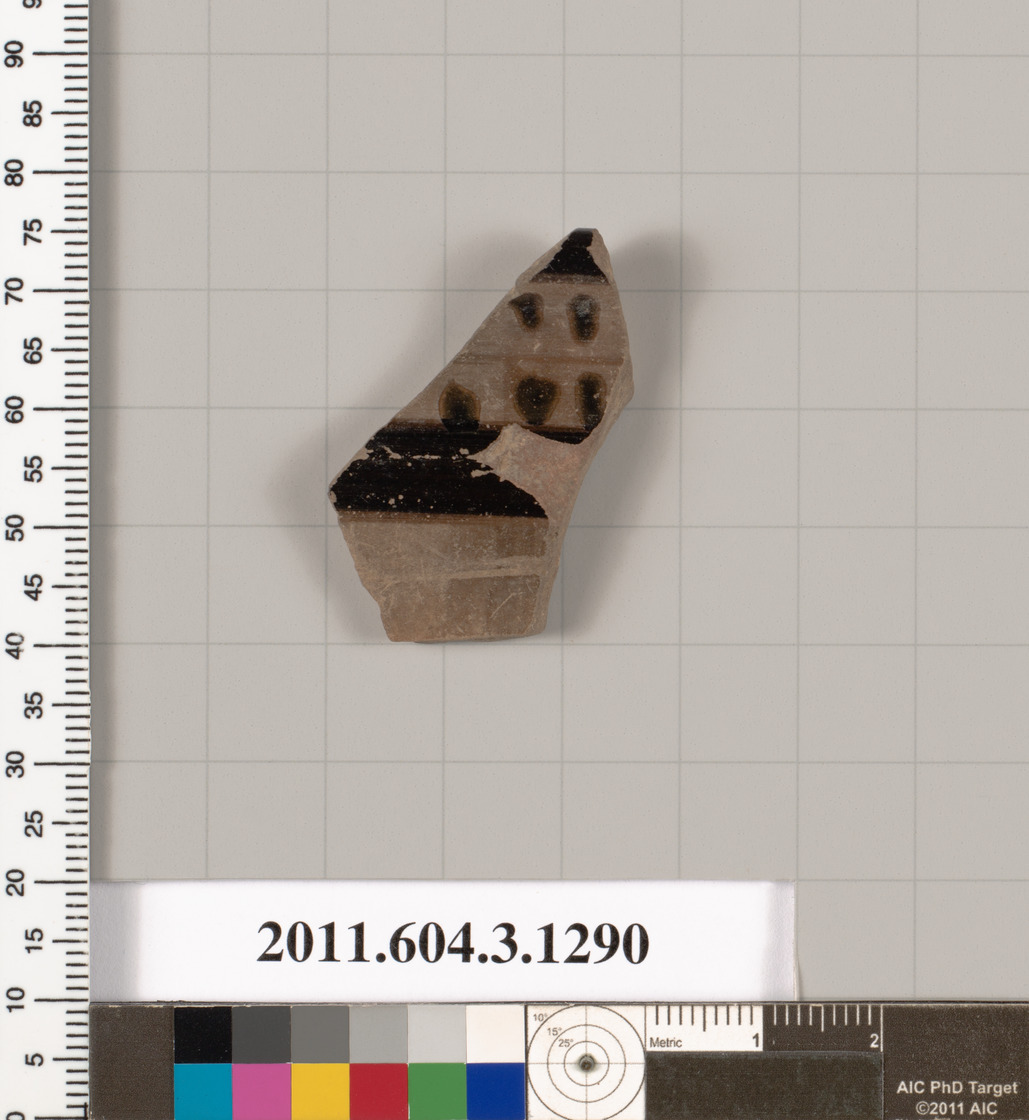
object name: skyphos fragment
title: Terracotta rim fragment of a skyphos (deep drinking cup)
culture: greek, attic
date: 500 BCE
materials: terracotta